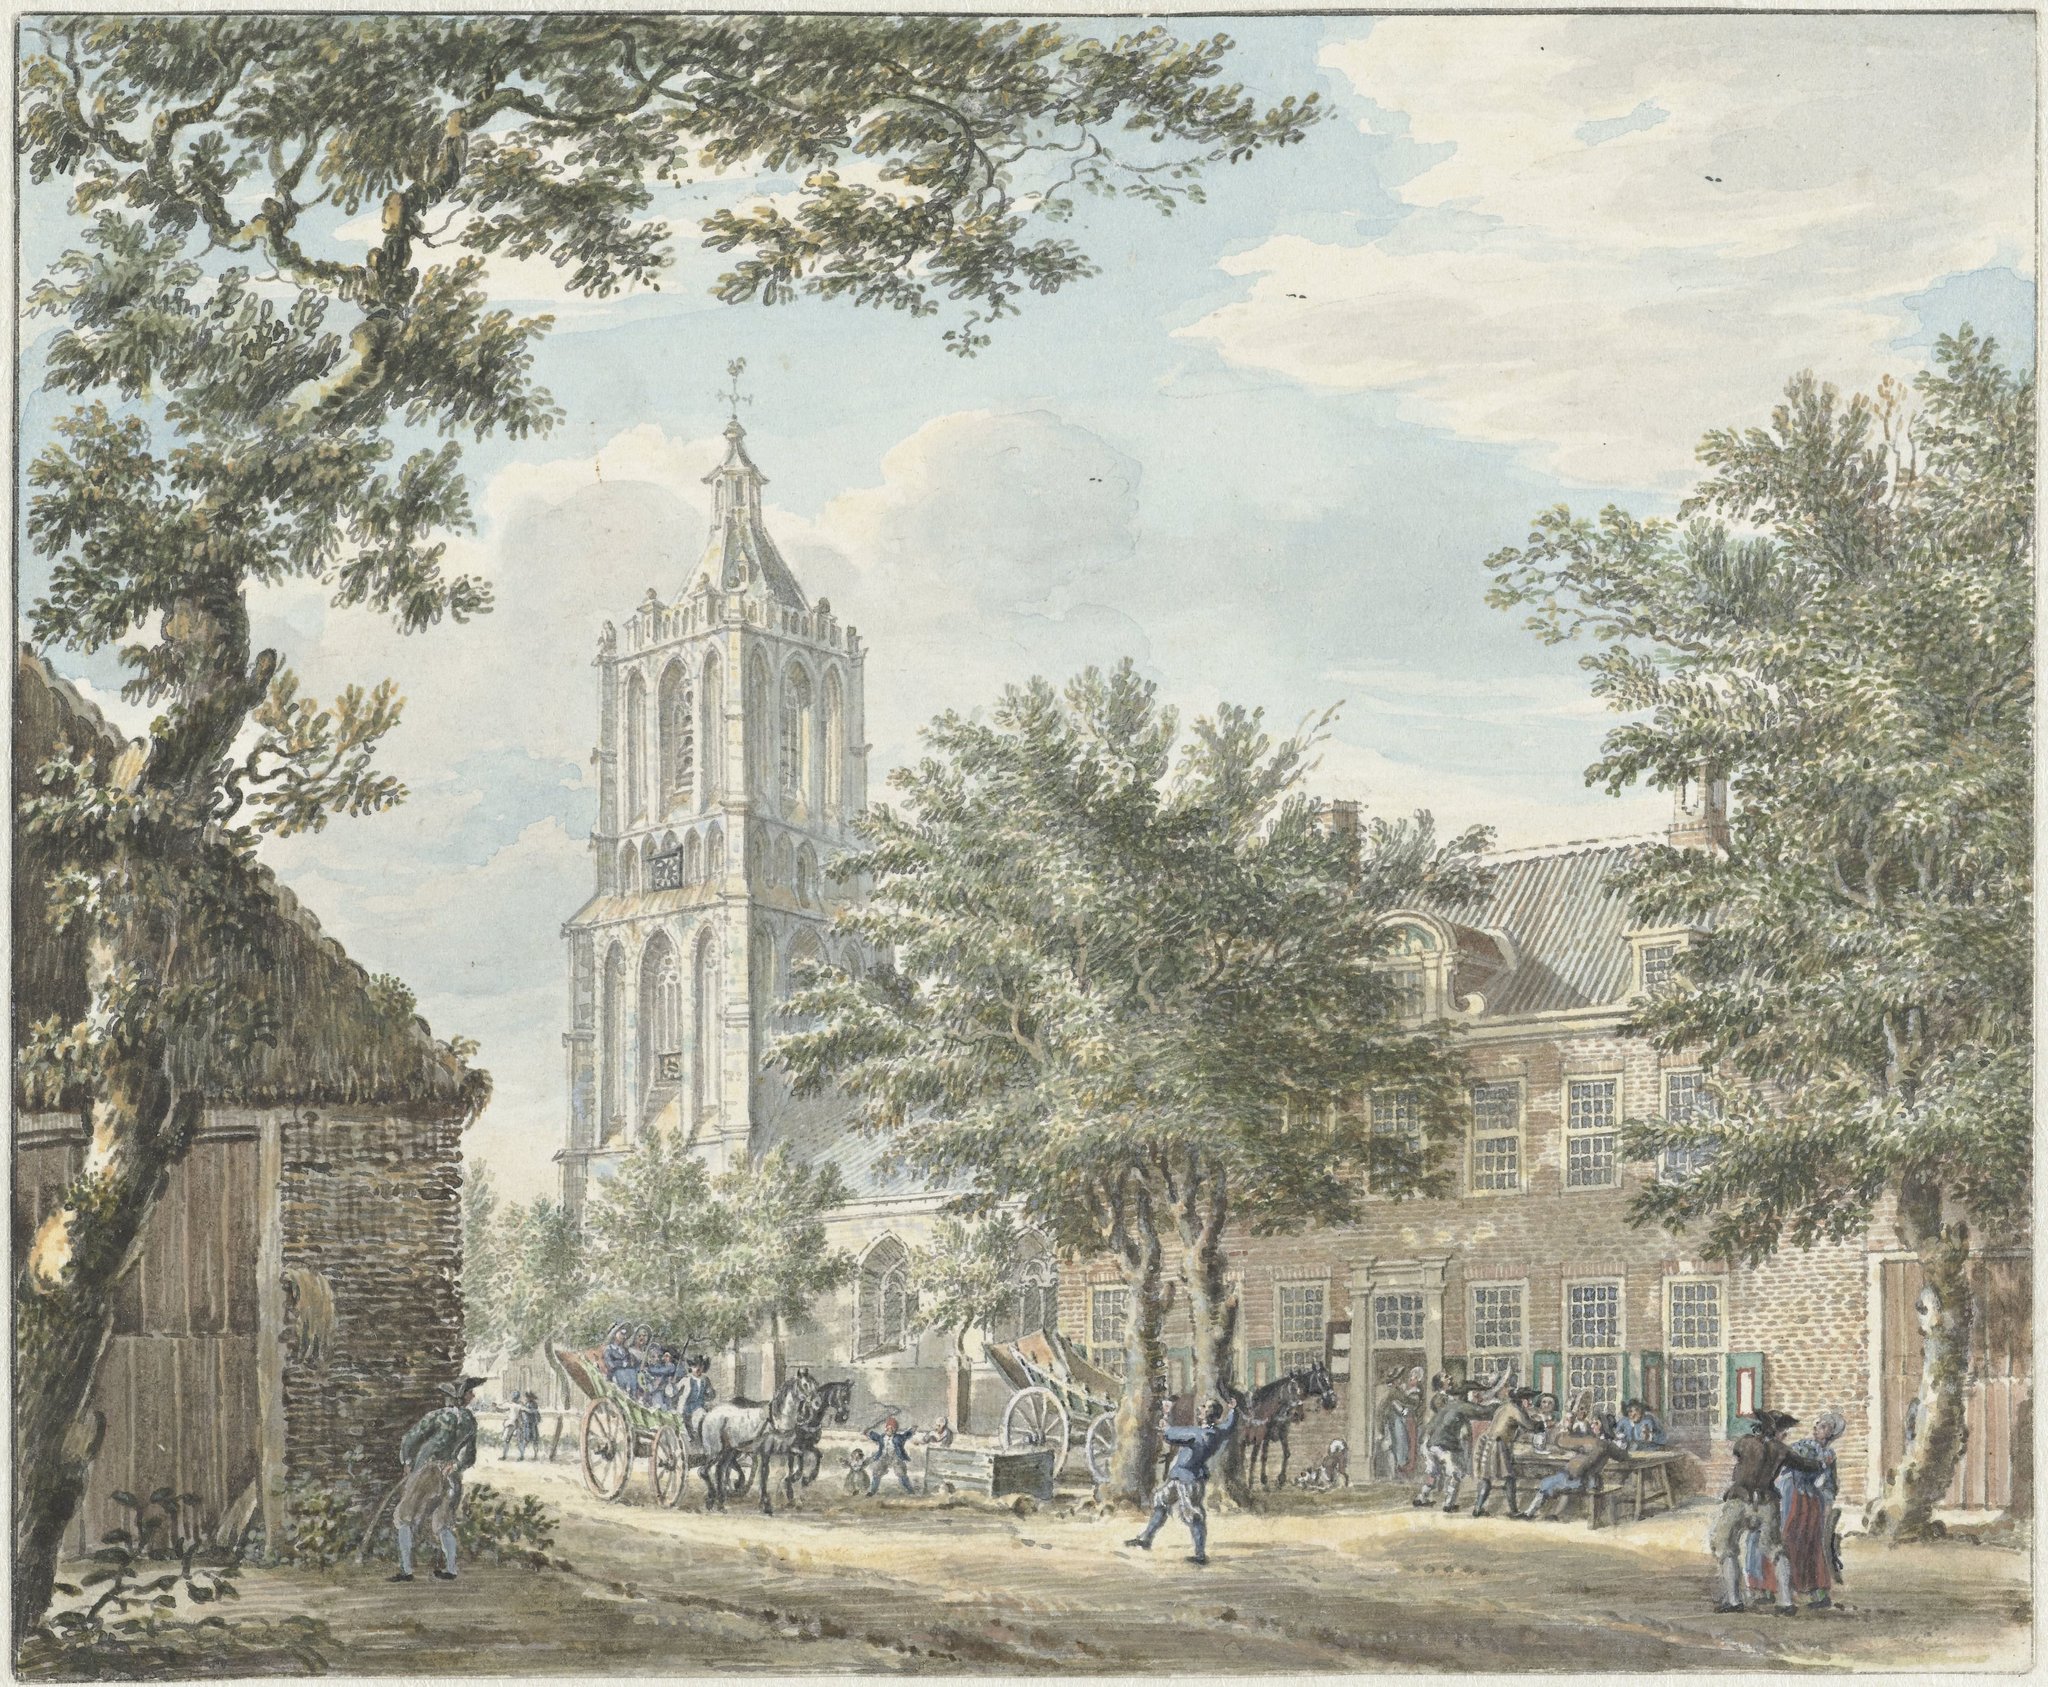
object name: watercolor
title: Vrolijke partij in het dorp Houten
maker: jan de beijer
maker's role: draughtsman, print maker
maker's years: 1703-1780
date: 1713-1780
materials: ink, paper, pencil, watercolor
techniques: brush, pen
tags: inn, coffee-house, public house, etc., public road